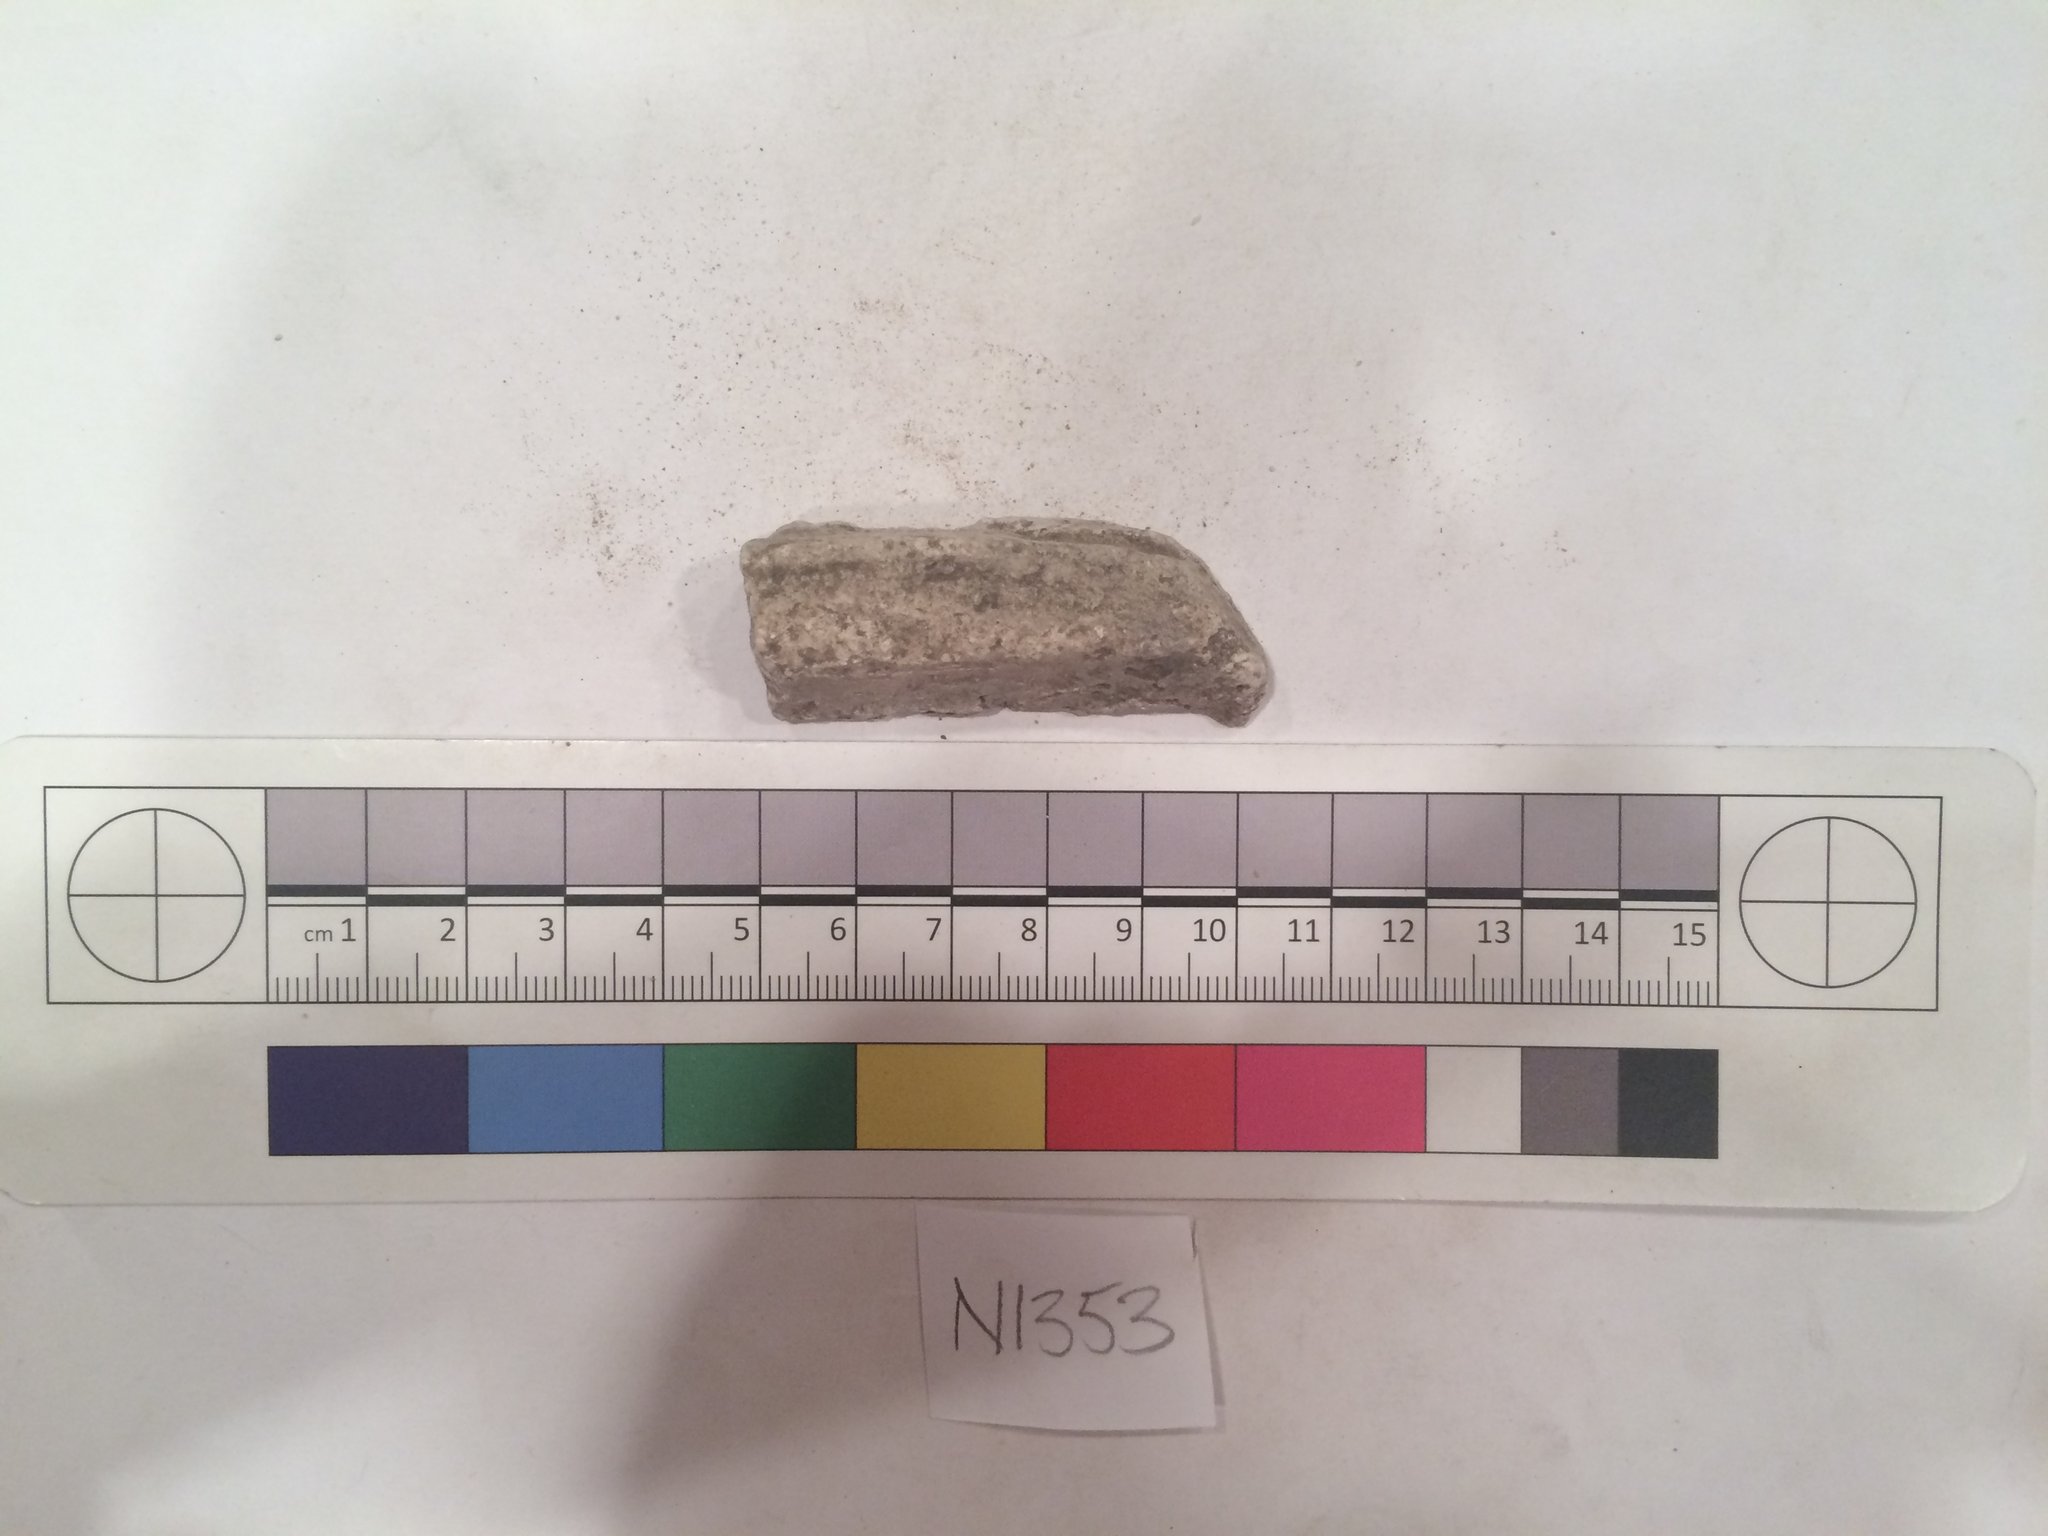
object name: fragment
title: Stucco Fragment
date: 701-1200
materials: plaster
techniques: carving, painting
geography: iran